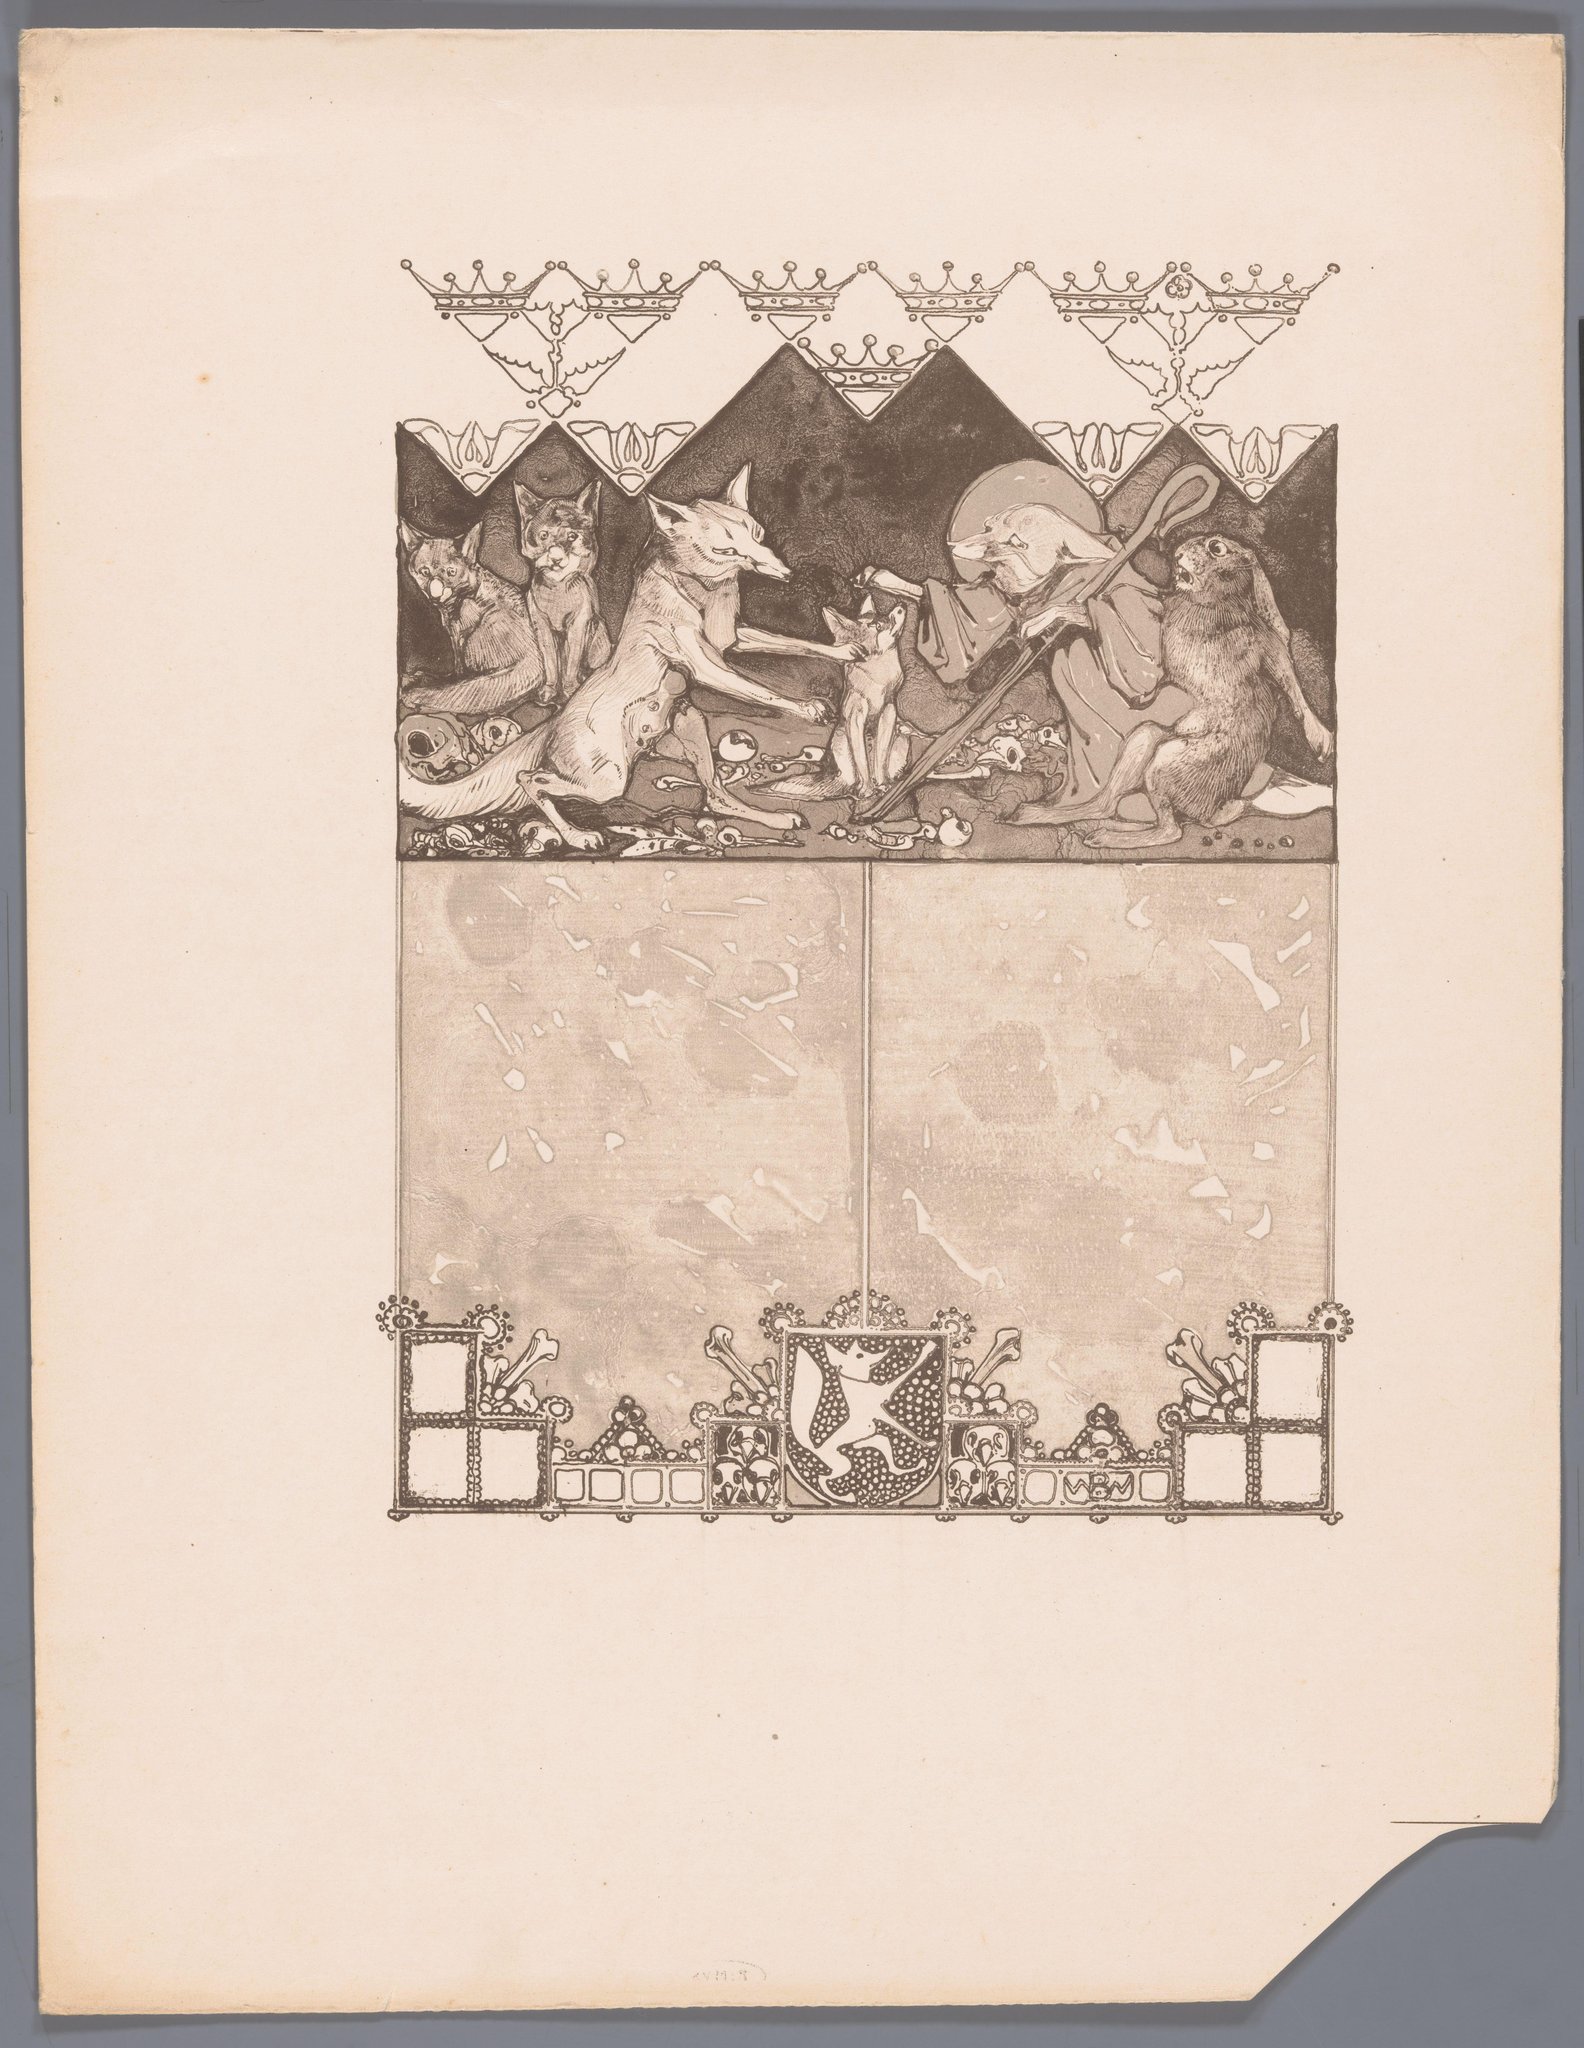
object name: boekillustratie ontwerp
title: Vos in monnikspij (Reinaert) met haas (Cuwaert) bij vossin (Hermeline) en welpen in vossenhol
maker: bernard willem wierink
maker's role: draughtsman, print maker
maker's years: 1856-1939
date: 1910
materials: paper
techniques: lithograph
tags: fable of reynard the fox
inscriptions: collector's mark: Lugt 2228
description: Ontwerp voor: Streuvels, Stijn (Frank Lateur). Reinaert de Vos naar verschillende uitgaven van het middeleeuwsche epos. Amsterdam: L.J. Veen, 1910.